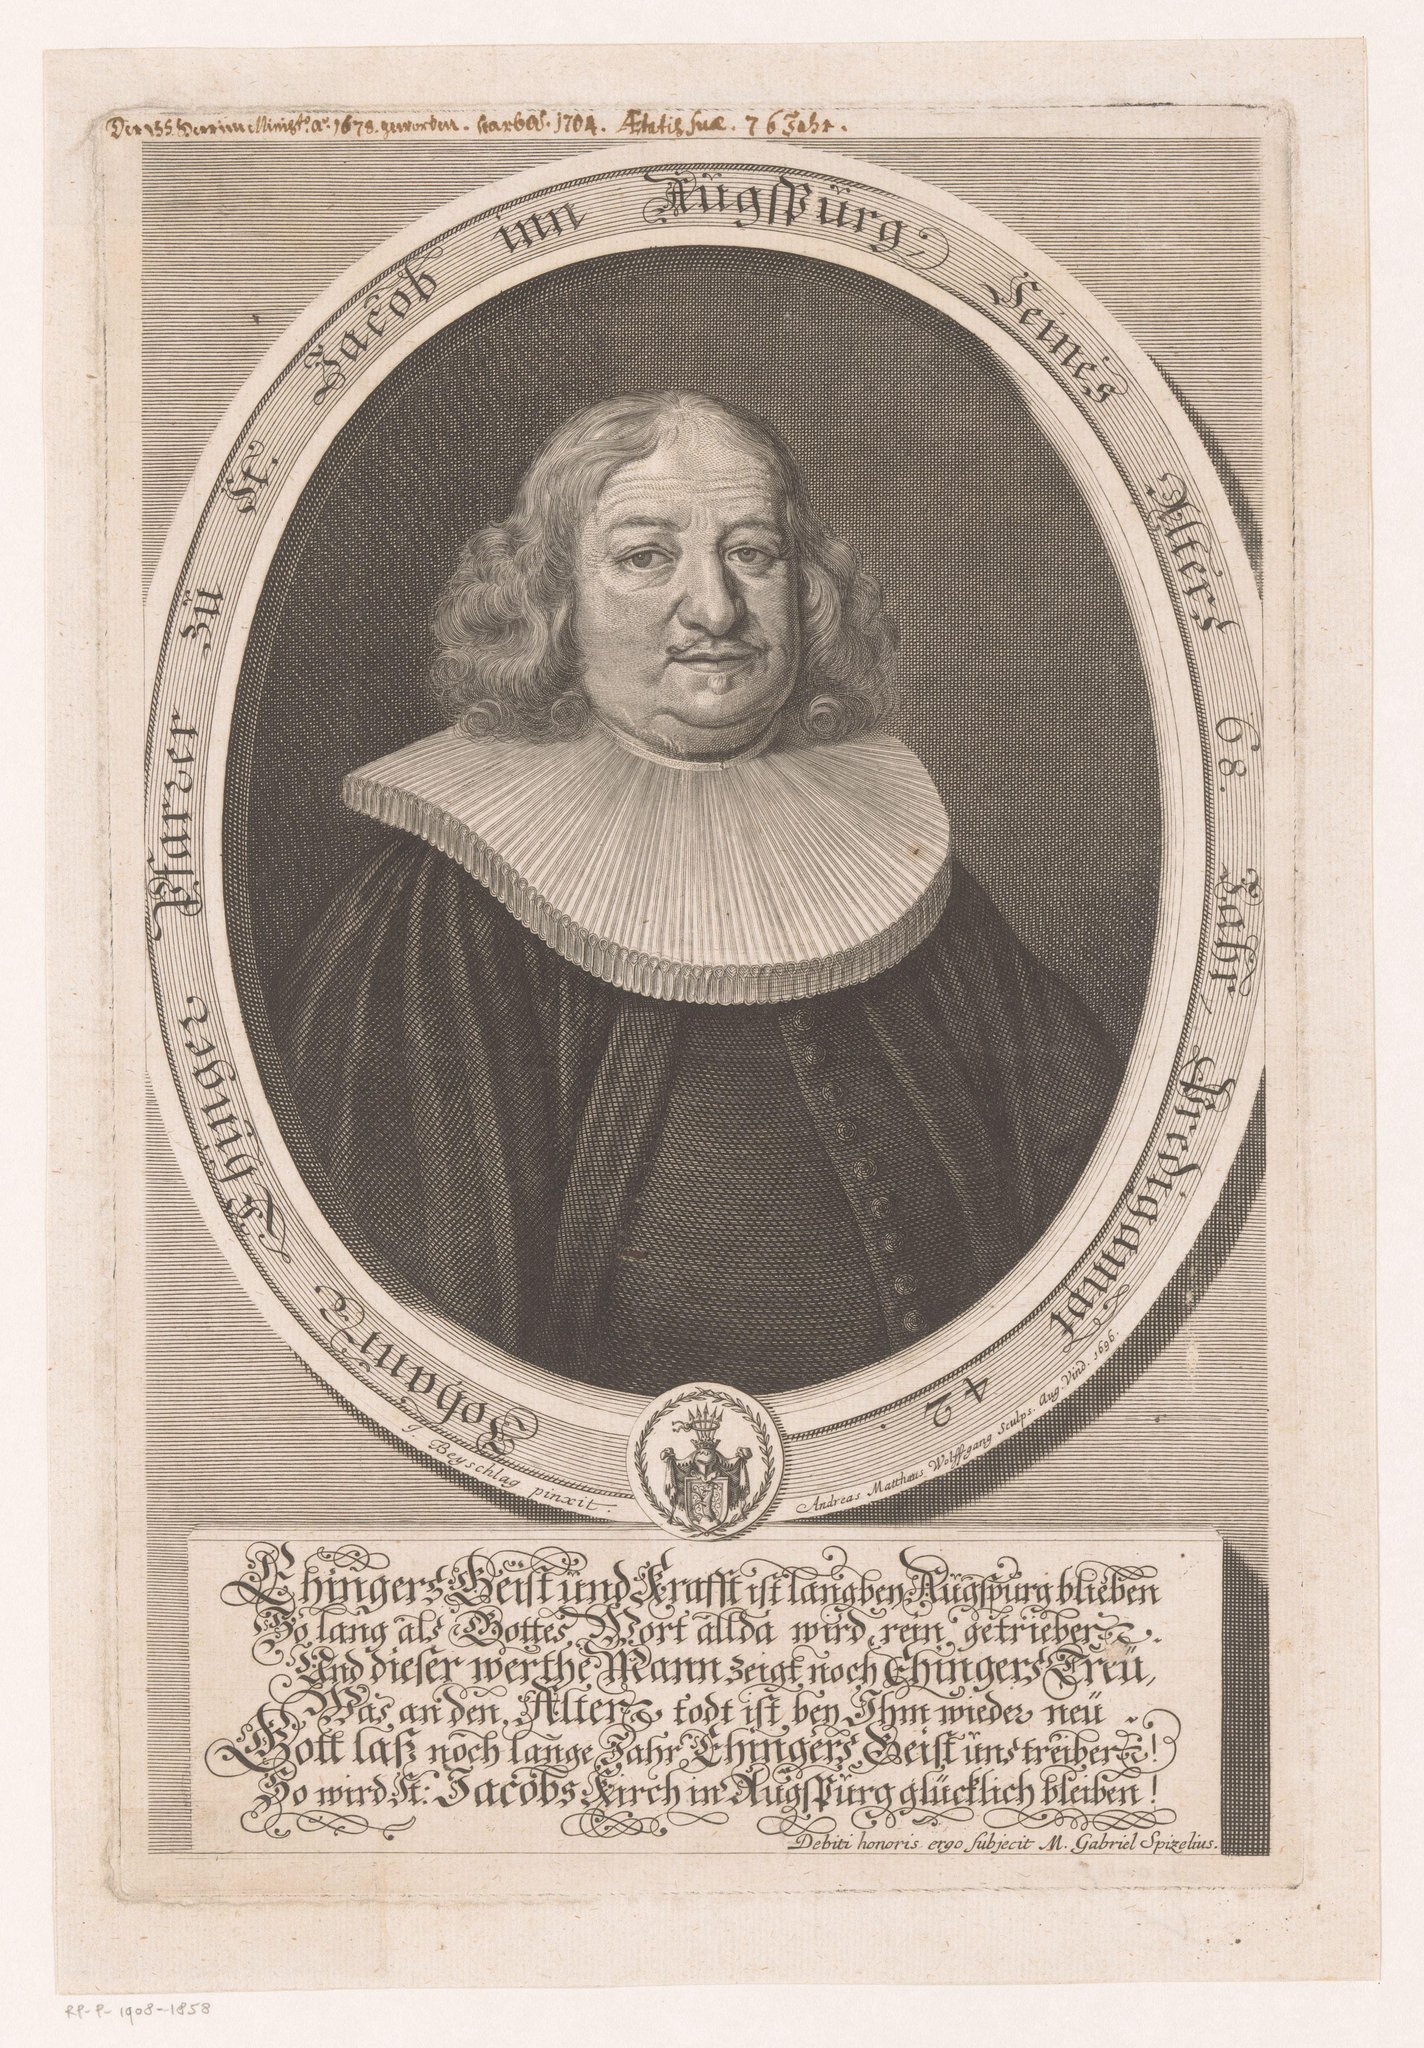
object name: print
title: Portret van Johann Ehinger II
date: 1696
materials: paper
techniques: engraving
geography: augsburg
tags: augsburg, historical persons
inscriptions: collector's mark: Lugt 2228, collector's mark: Lugt 9